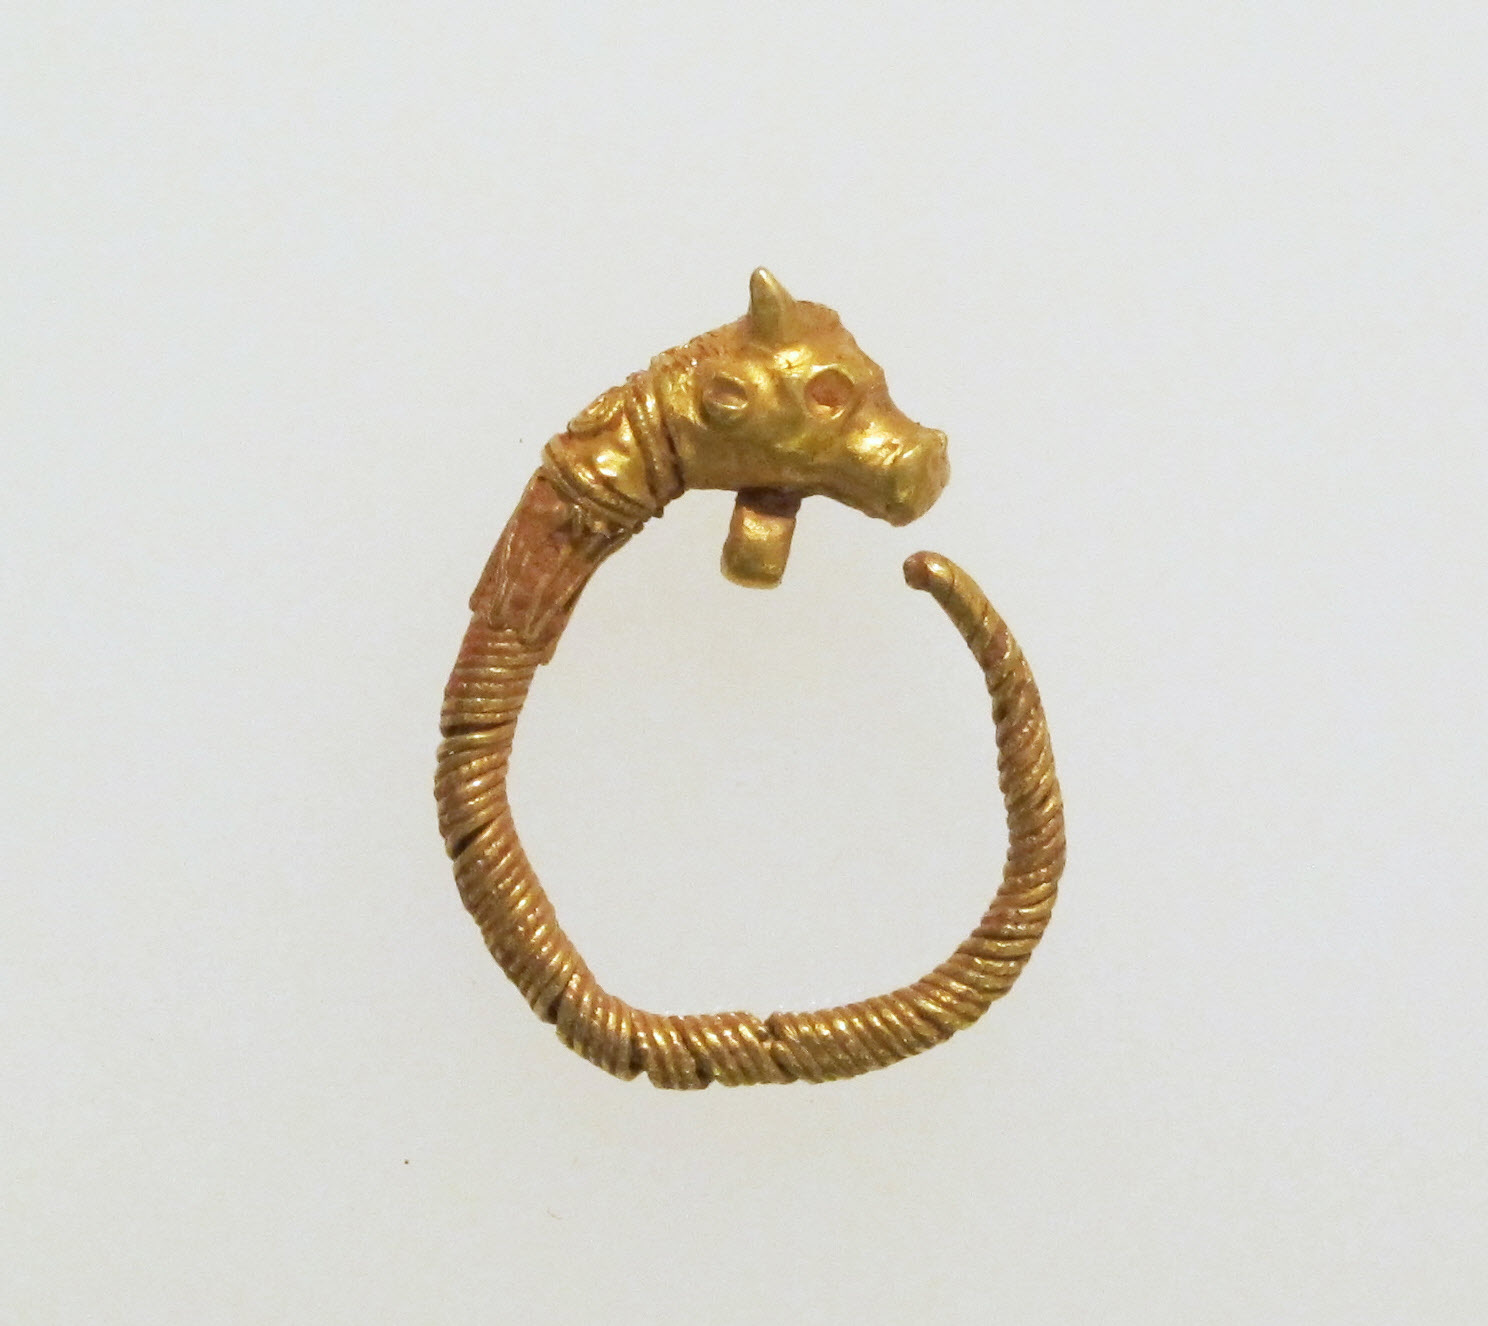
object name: earring with head of bull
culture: etruscan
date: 900-100 BCE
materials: gold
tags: bulls